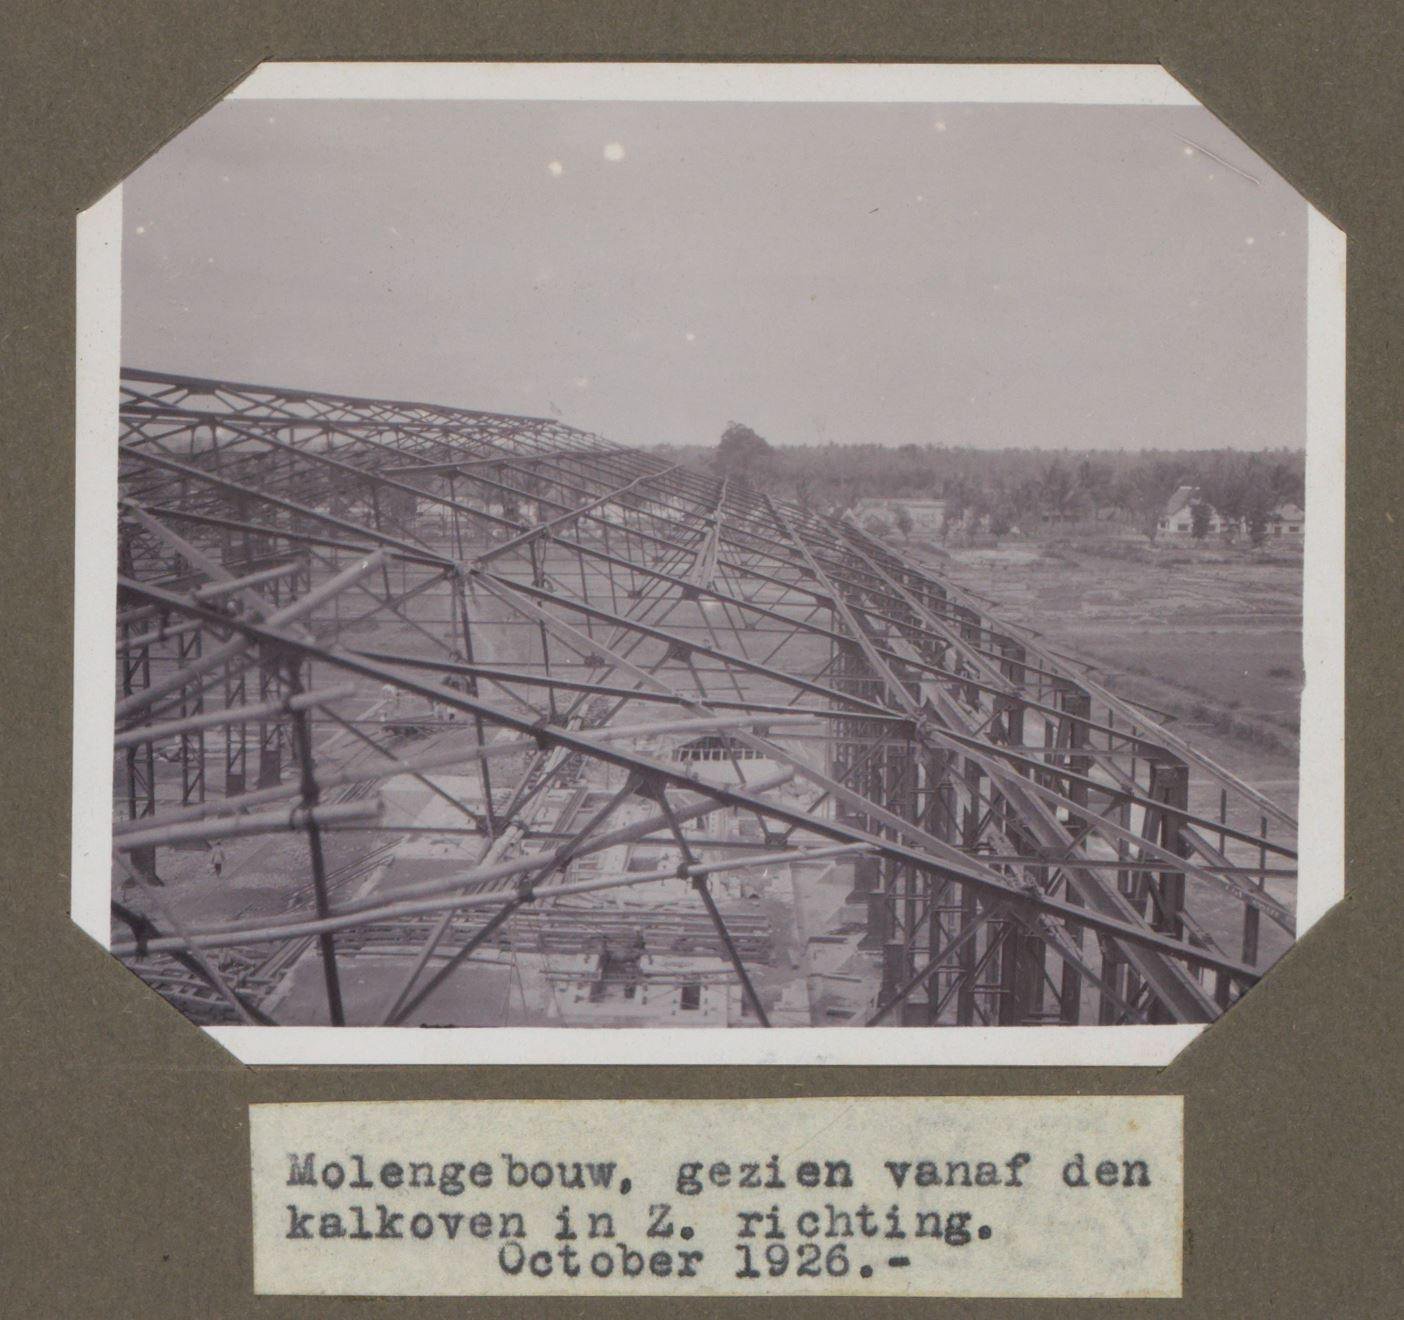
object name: photograph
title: Molengebouw, gezien vanaf den kalkoven in Z. richting. October 1926.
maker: Anonymous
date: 1910-1926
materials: photographic support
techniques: gelatin silver print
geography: east java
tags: colonial system, trade-company, making the overground structures (~ building activities), industrial structures, (non-fruit) products of plants or trees: sugarcane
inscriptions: inscription: ‘Molengebouw, gezien vanaf den kalkoven in Z. richting. October 1926.’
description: Gezicht op het molengebouw in aanbouw op het fabrieksterrein, oktober 1926. Onderdeel van het fotoalbum met foto's van de opbouw van de suikerfabriek te Goenoengsari op Oost-Java door de Handels Vereniging Amsterdam 1926-1927.